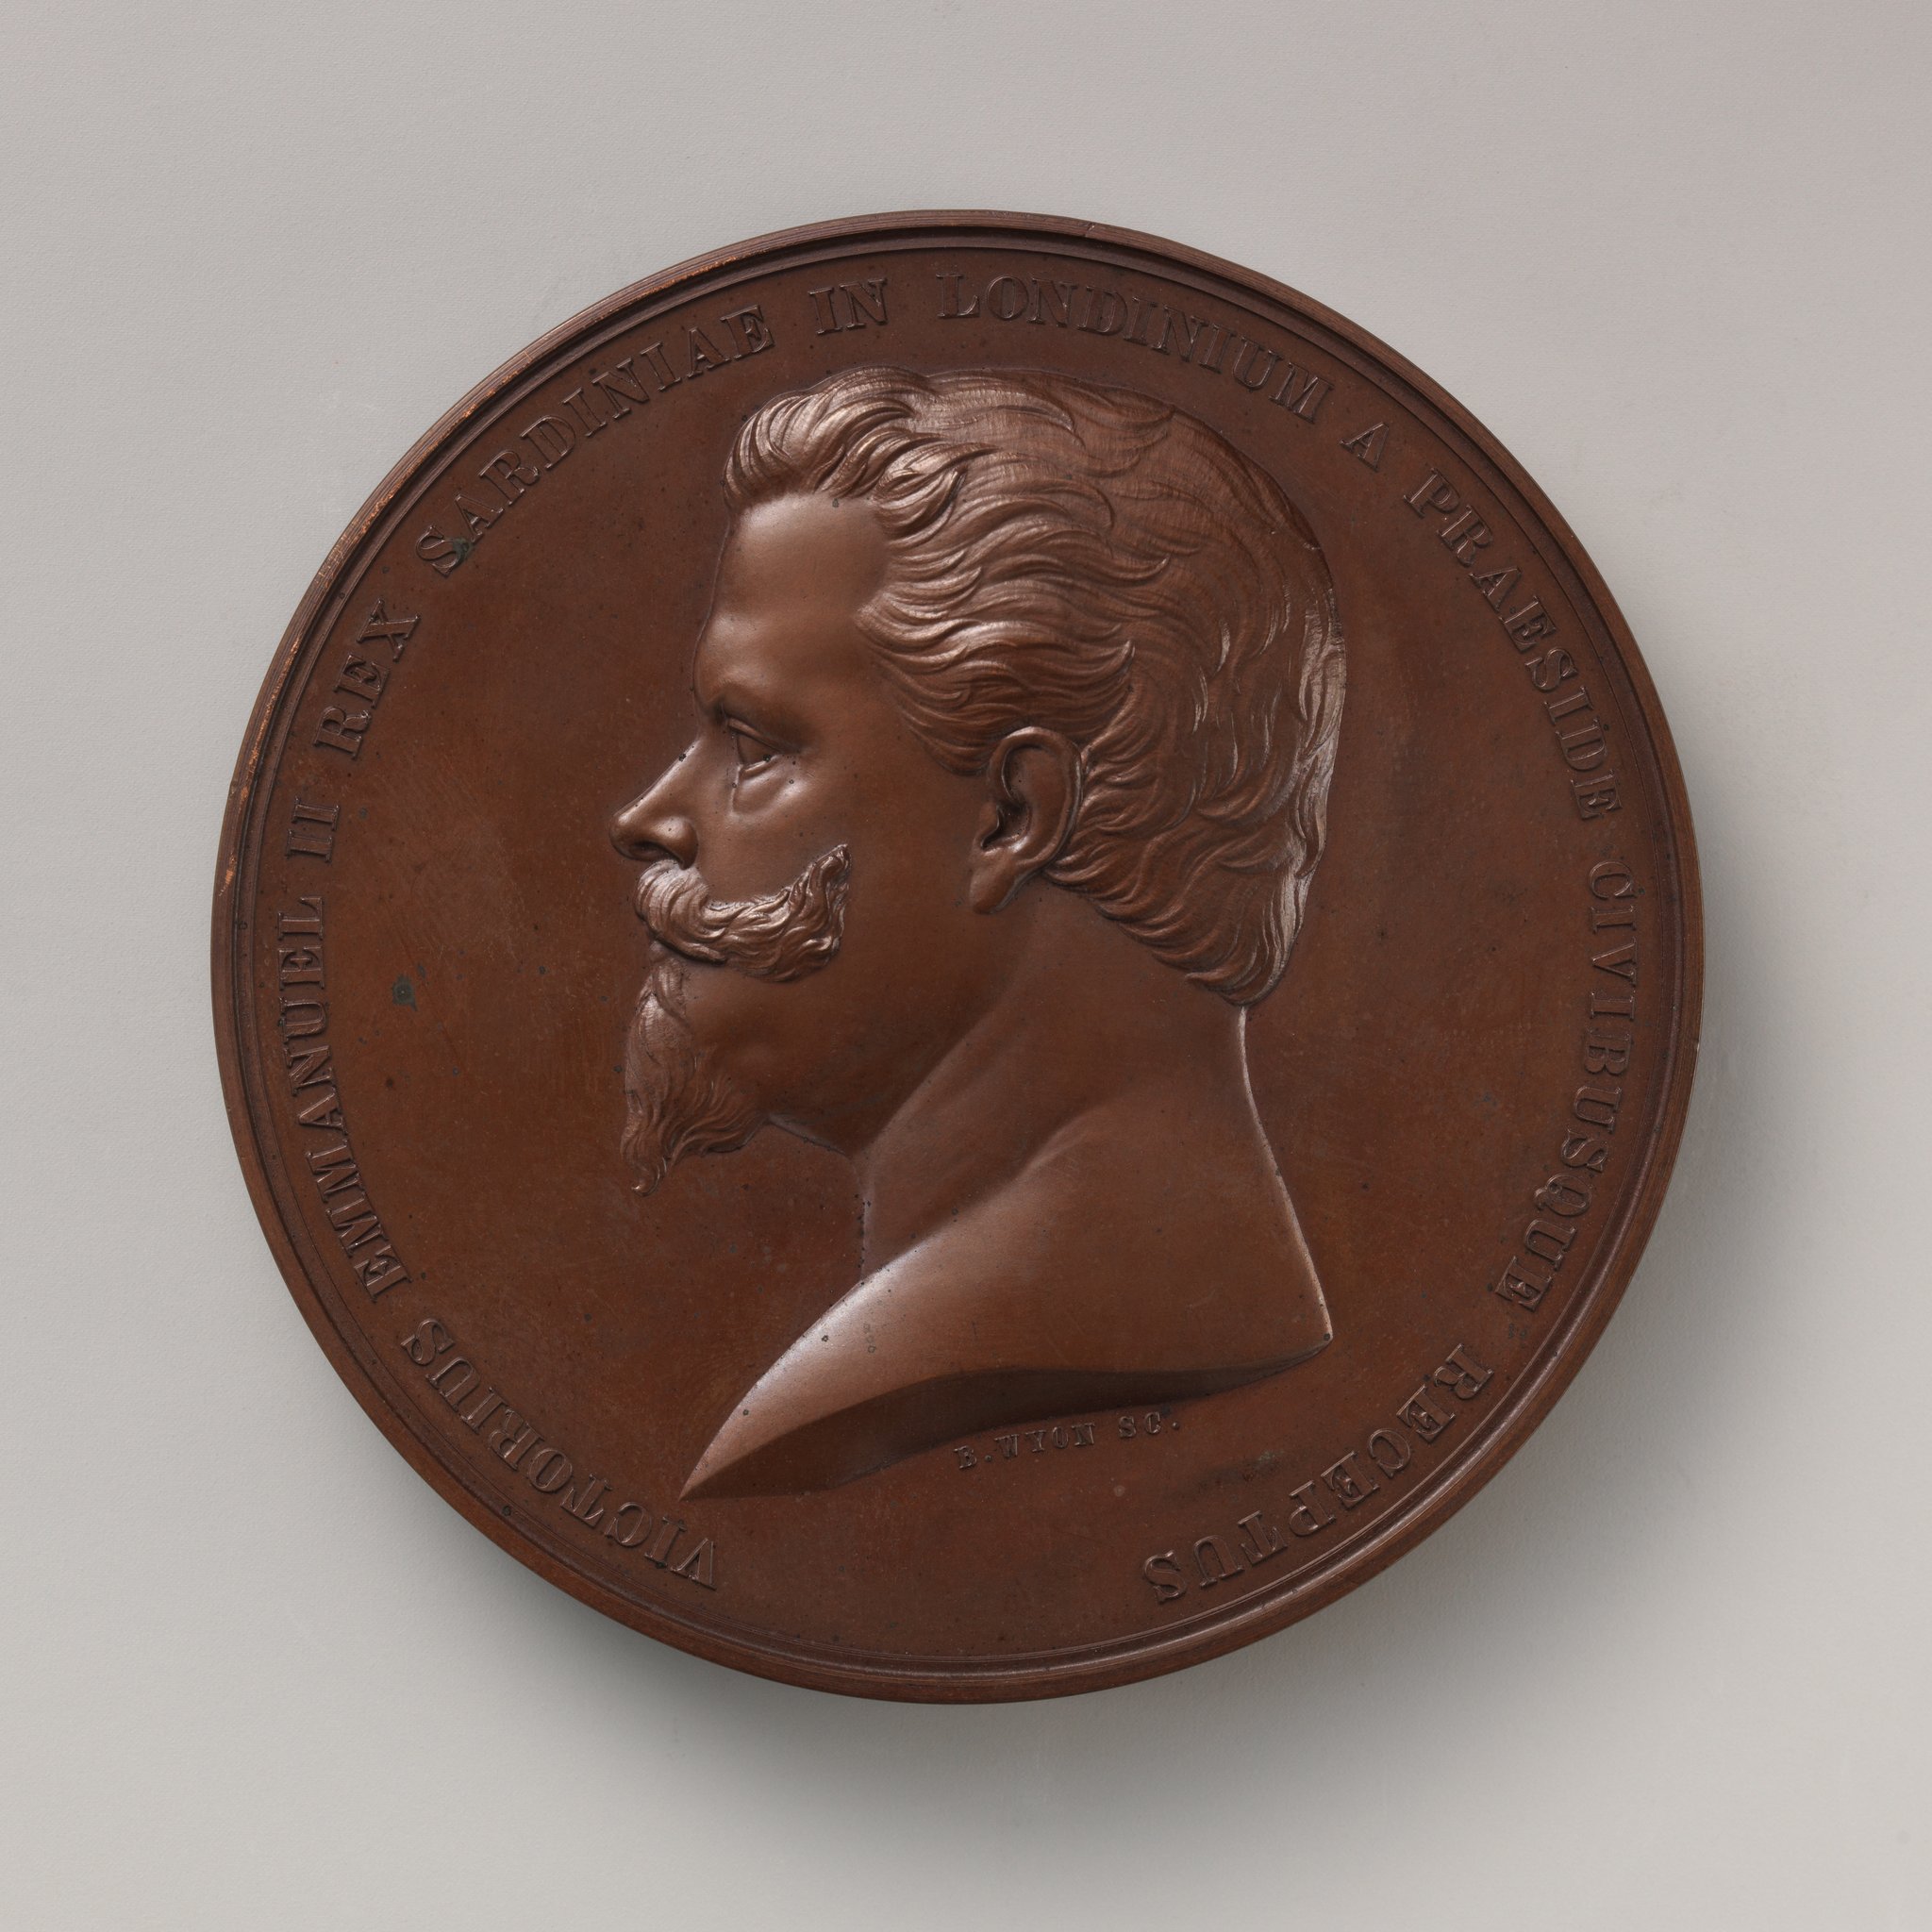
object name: medal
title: To Commemorate the Reception by the City of London of King Victor Emanuel, of Sardinia, December 4, 1855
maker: benjamin wyon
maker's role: artist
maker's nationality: british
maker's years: 1802-1858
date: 1855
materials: bronze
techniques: struck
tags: men,profiles